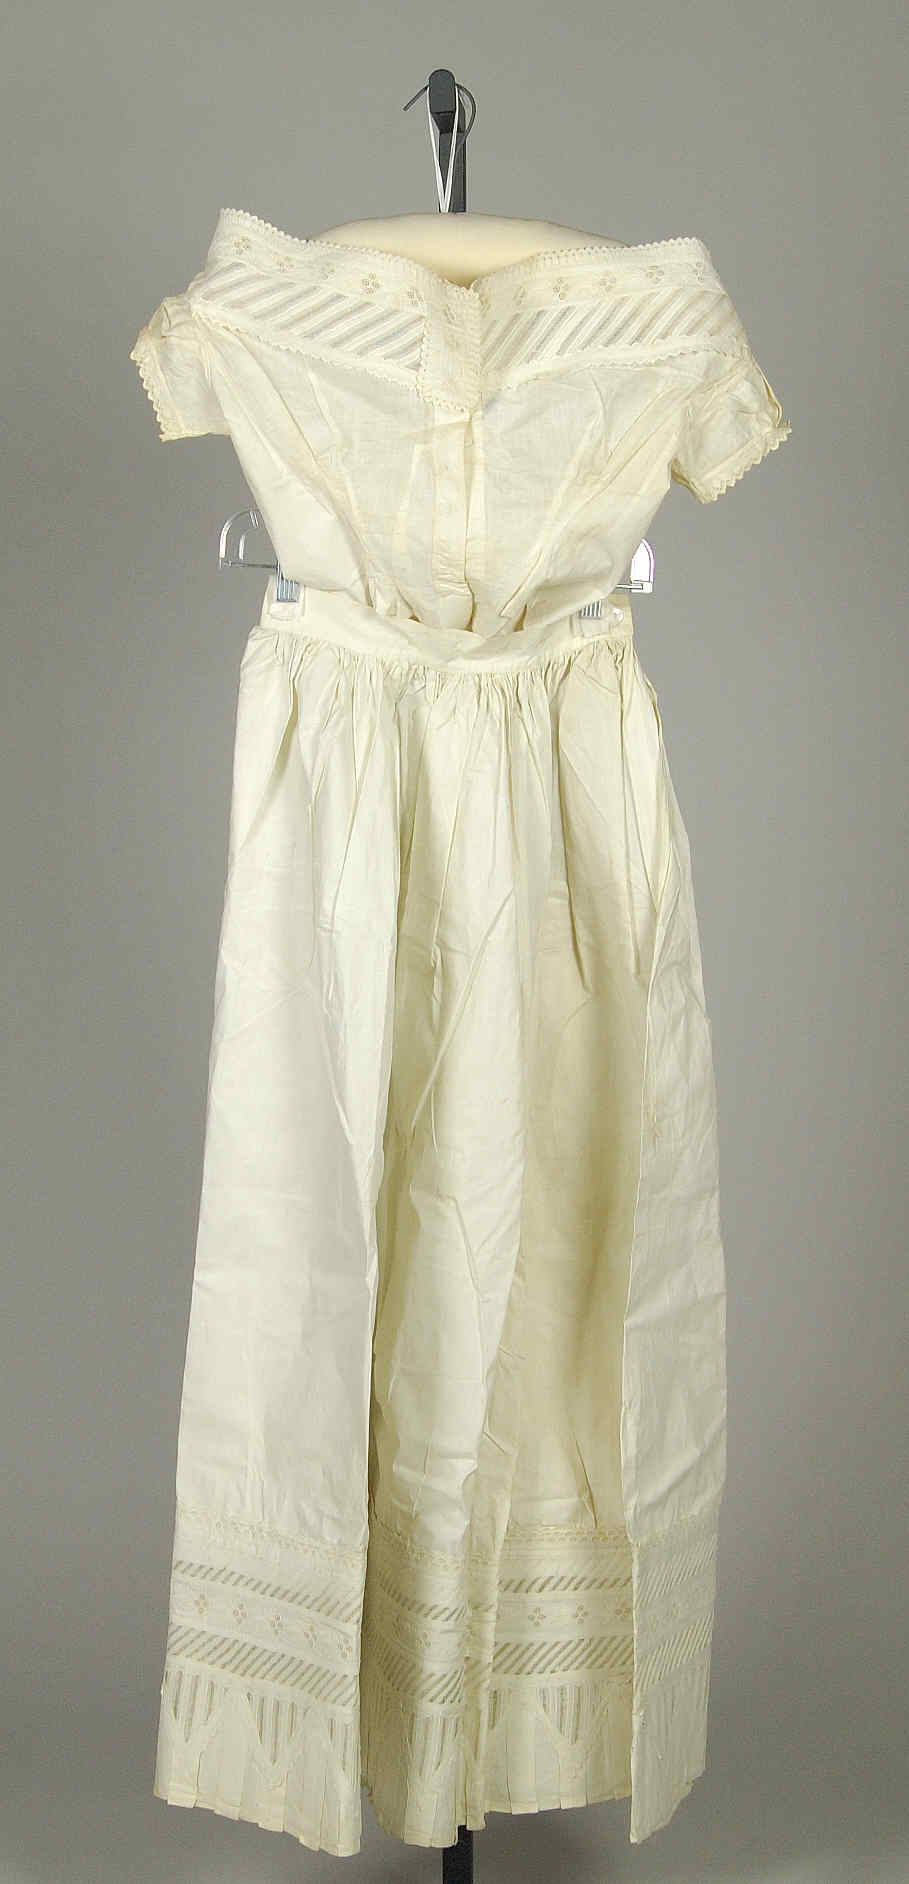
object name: lingerie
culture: american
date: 1860-1880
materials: cotton